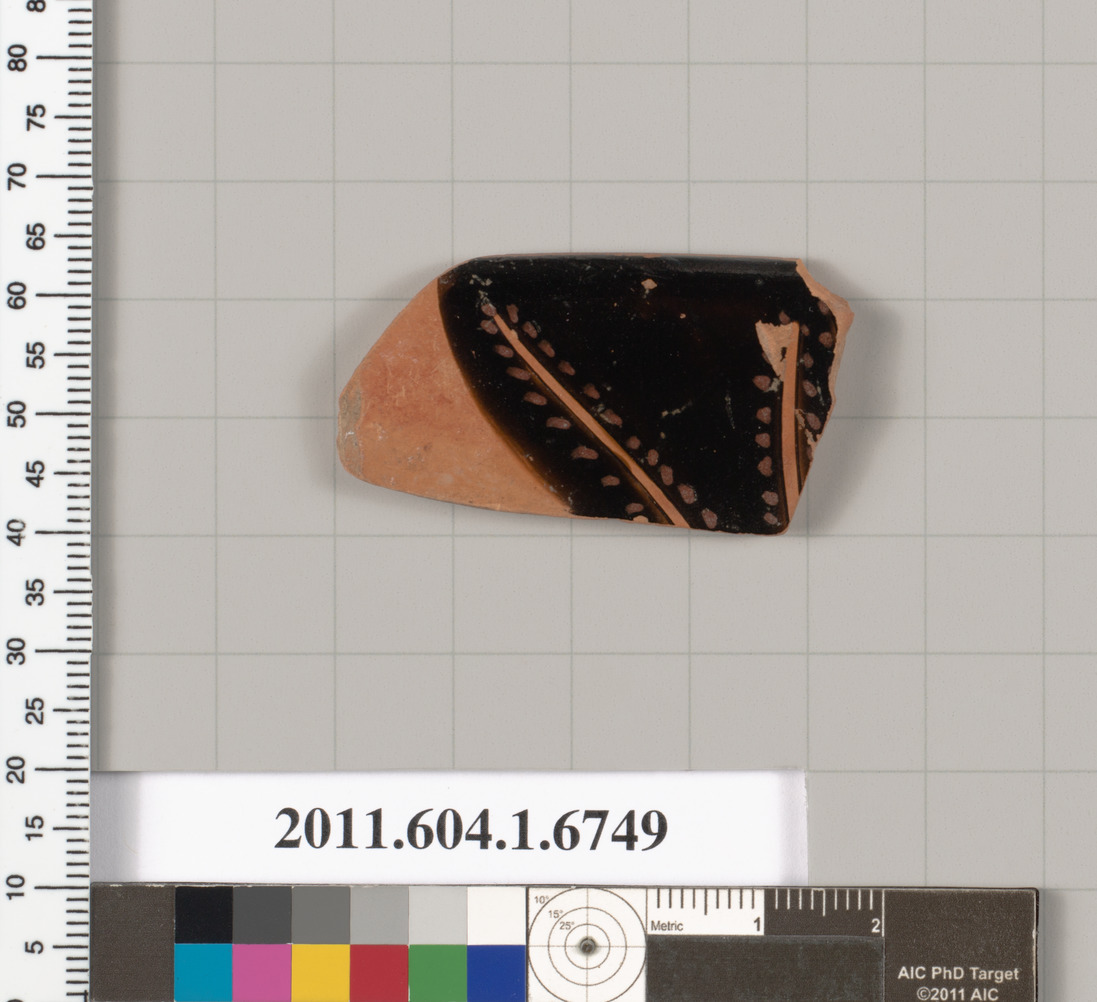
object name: kylix fragment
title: Terracotta rim fragment of a kylix (drinking cup)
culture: greek, attic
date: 490-470 BCE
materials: terracotta